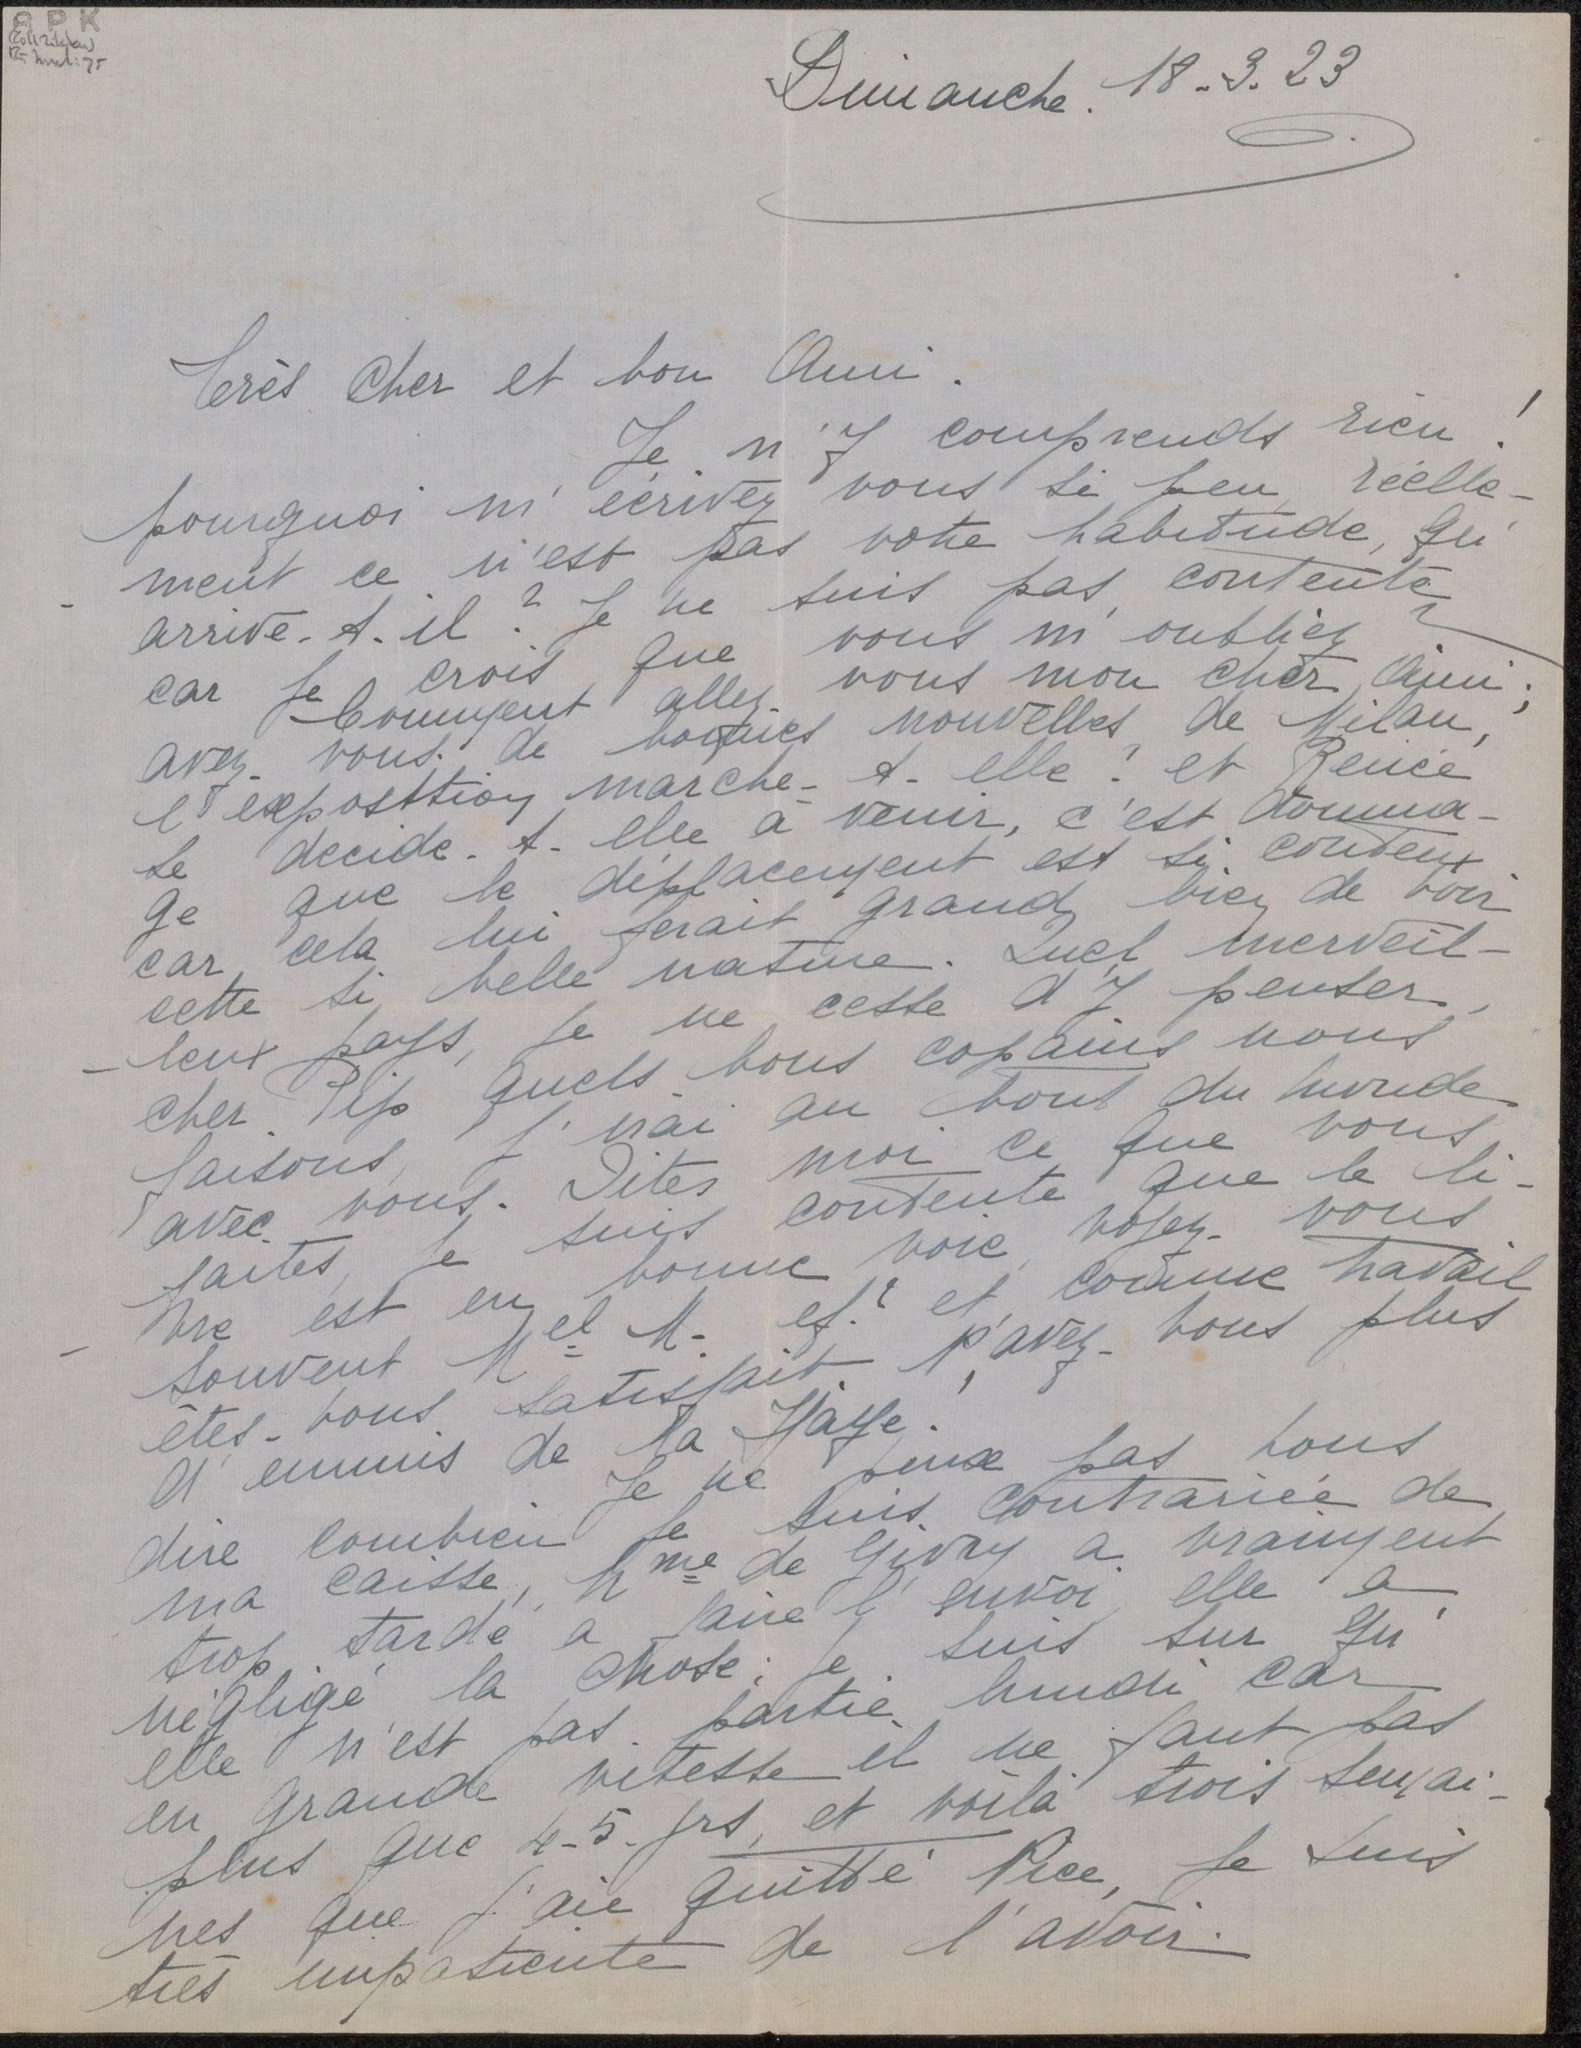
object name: letter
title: Brief aan Philip Zilcken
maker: rose imel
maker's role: draughtsman, painter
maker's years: 1901-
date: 1923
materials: ink, paper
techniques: pen, writing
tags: the hague, painter, draughtsman, philip zilcken, music, workshop, studio of the artist (in general), exhibition ~ art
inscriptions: collector's mark: ‘RPK’